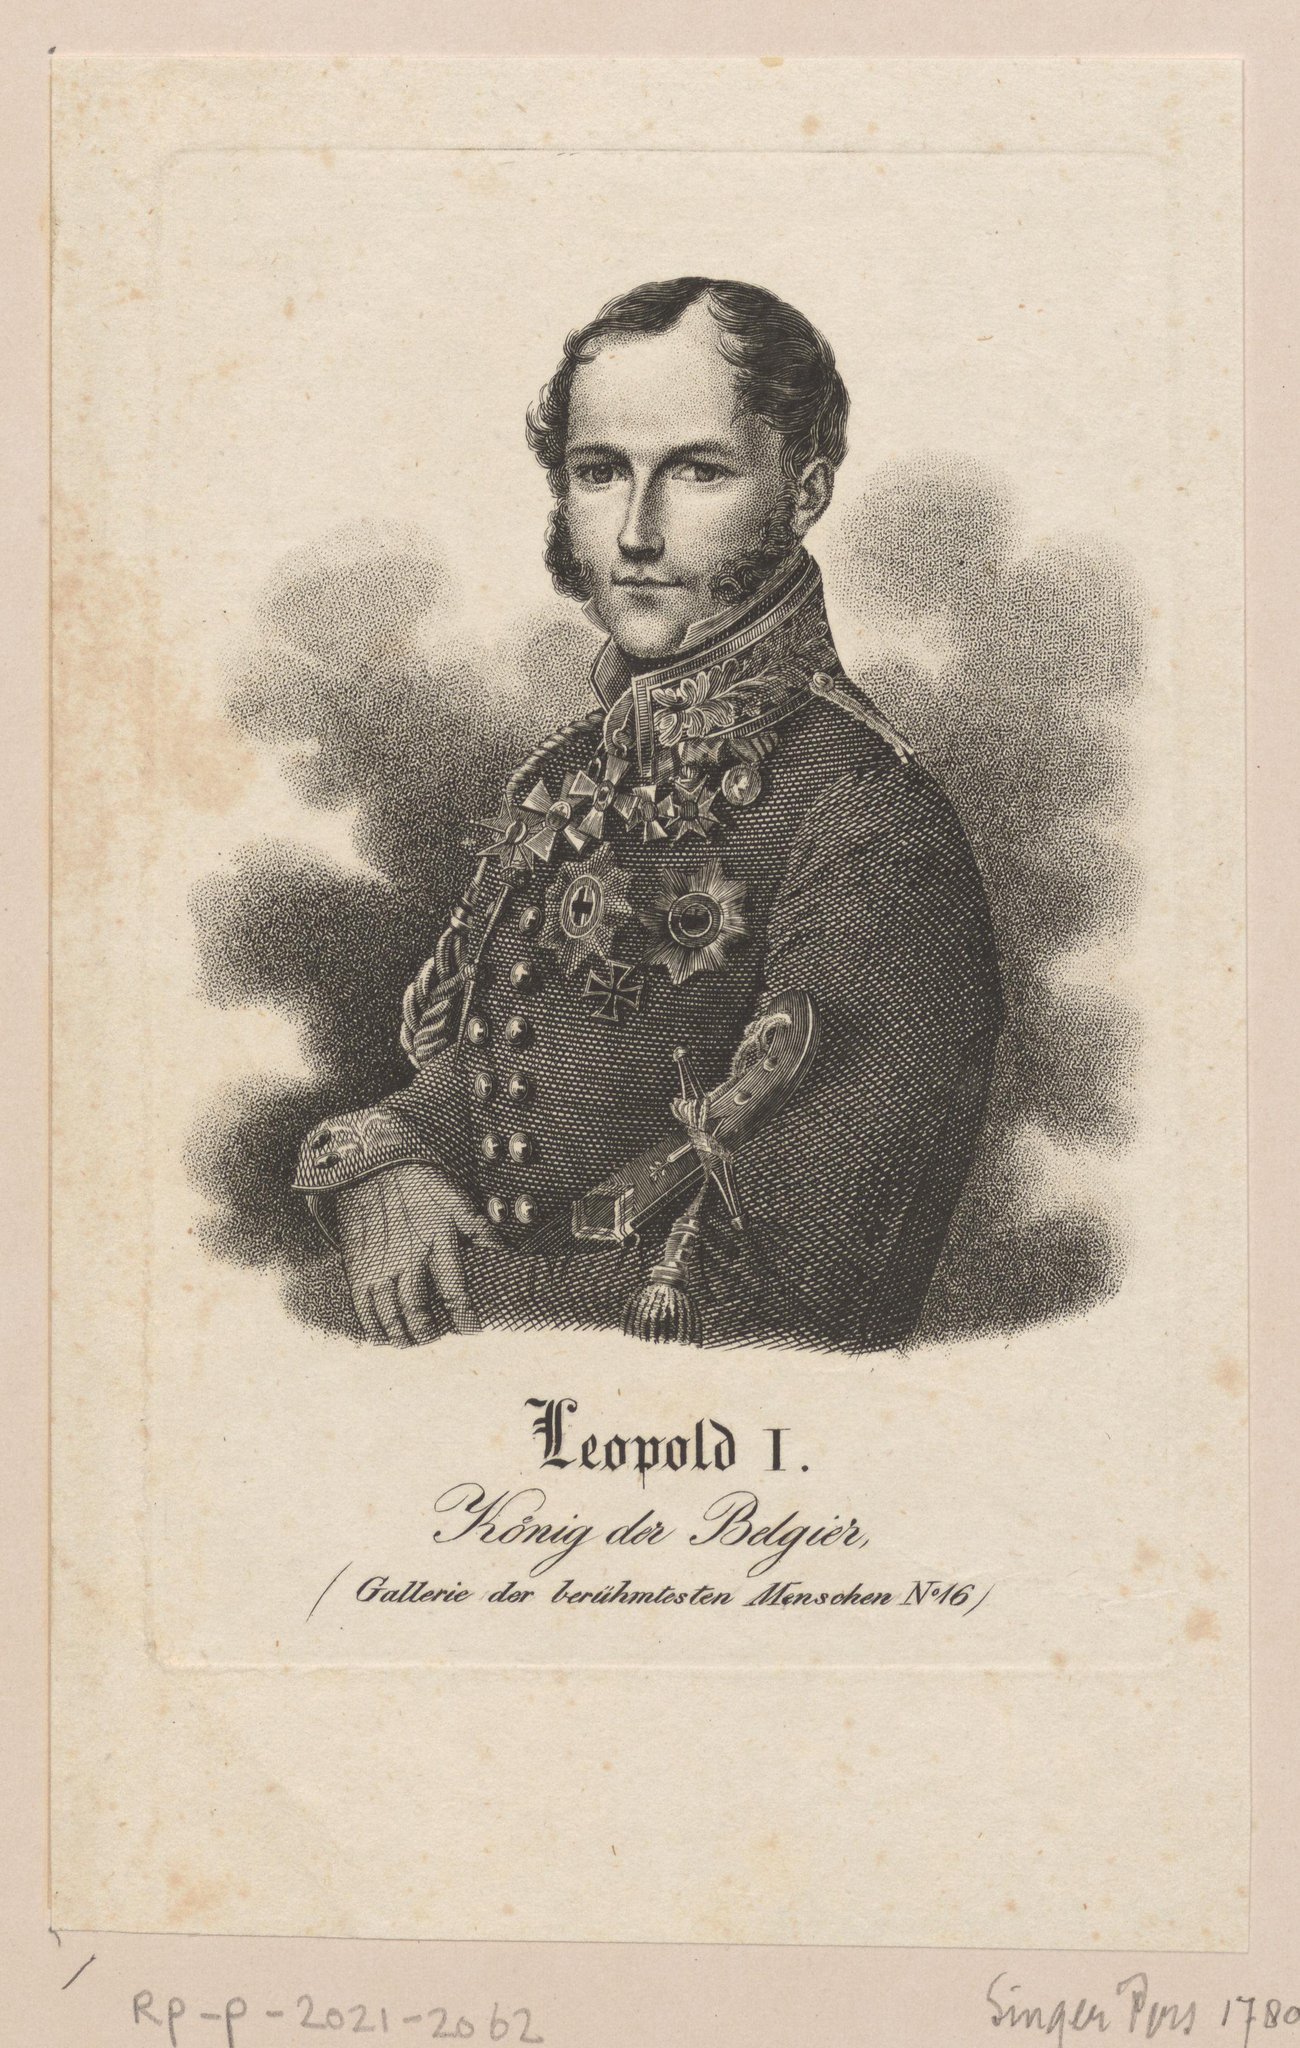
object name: print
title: Portret van Leopold I van België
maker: Anonymous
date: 1831-1840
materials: paper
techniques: engraving, etching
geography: germany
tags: laeken, leopold i (koning der belgen), knighthood order, historical persons, hacking and thrusting weapons: sword, (military) uniforms, king